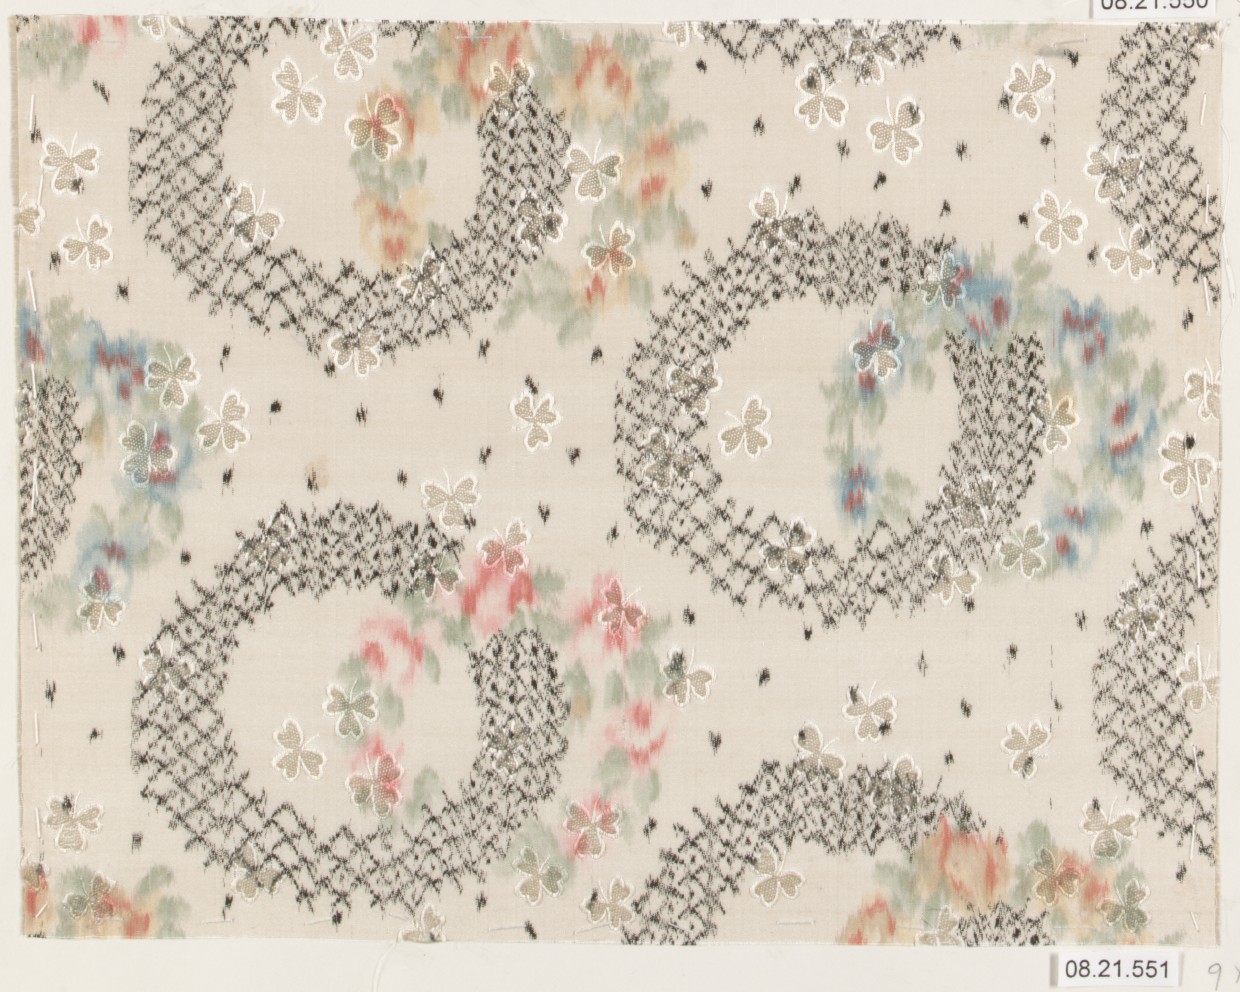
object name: textile sample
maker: Anonymous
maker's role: designer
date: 1900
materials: silk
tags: flowers